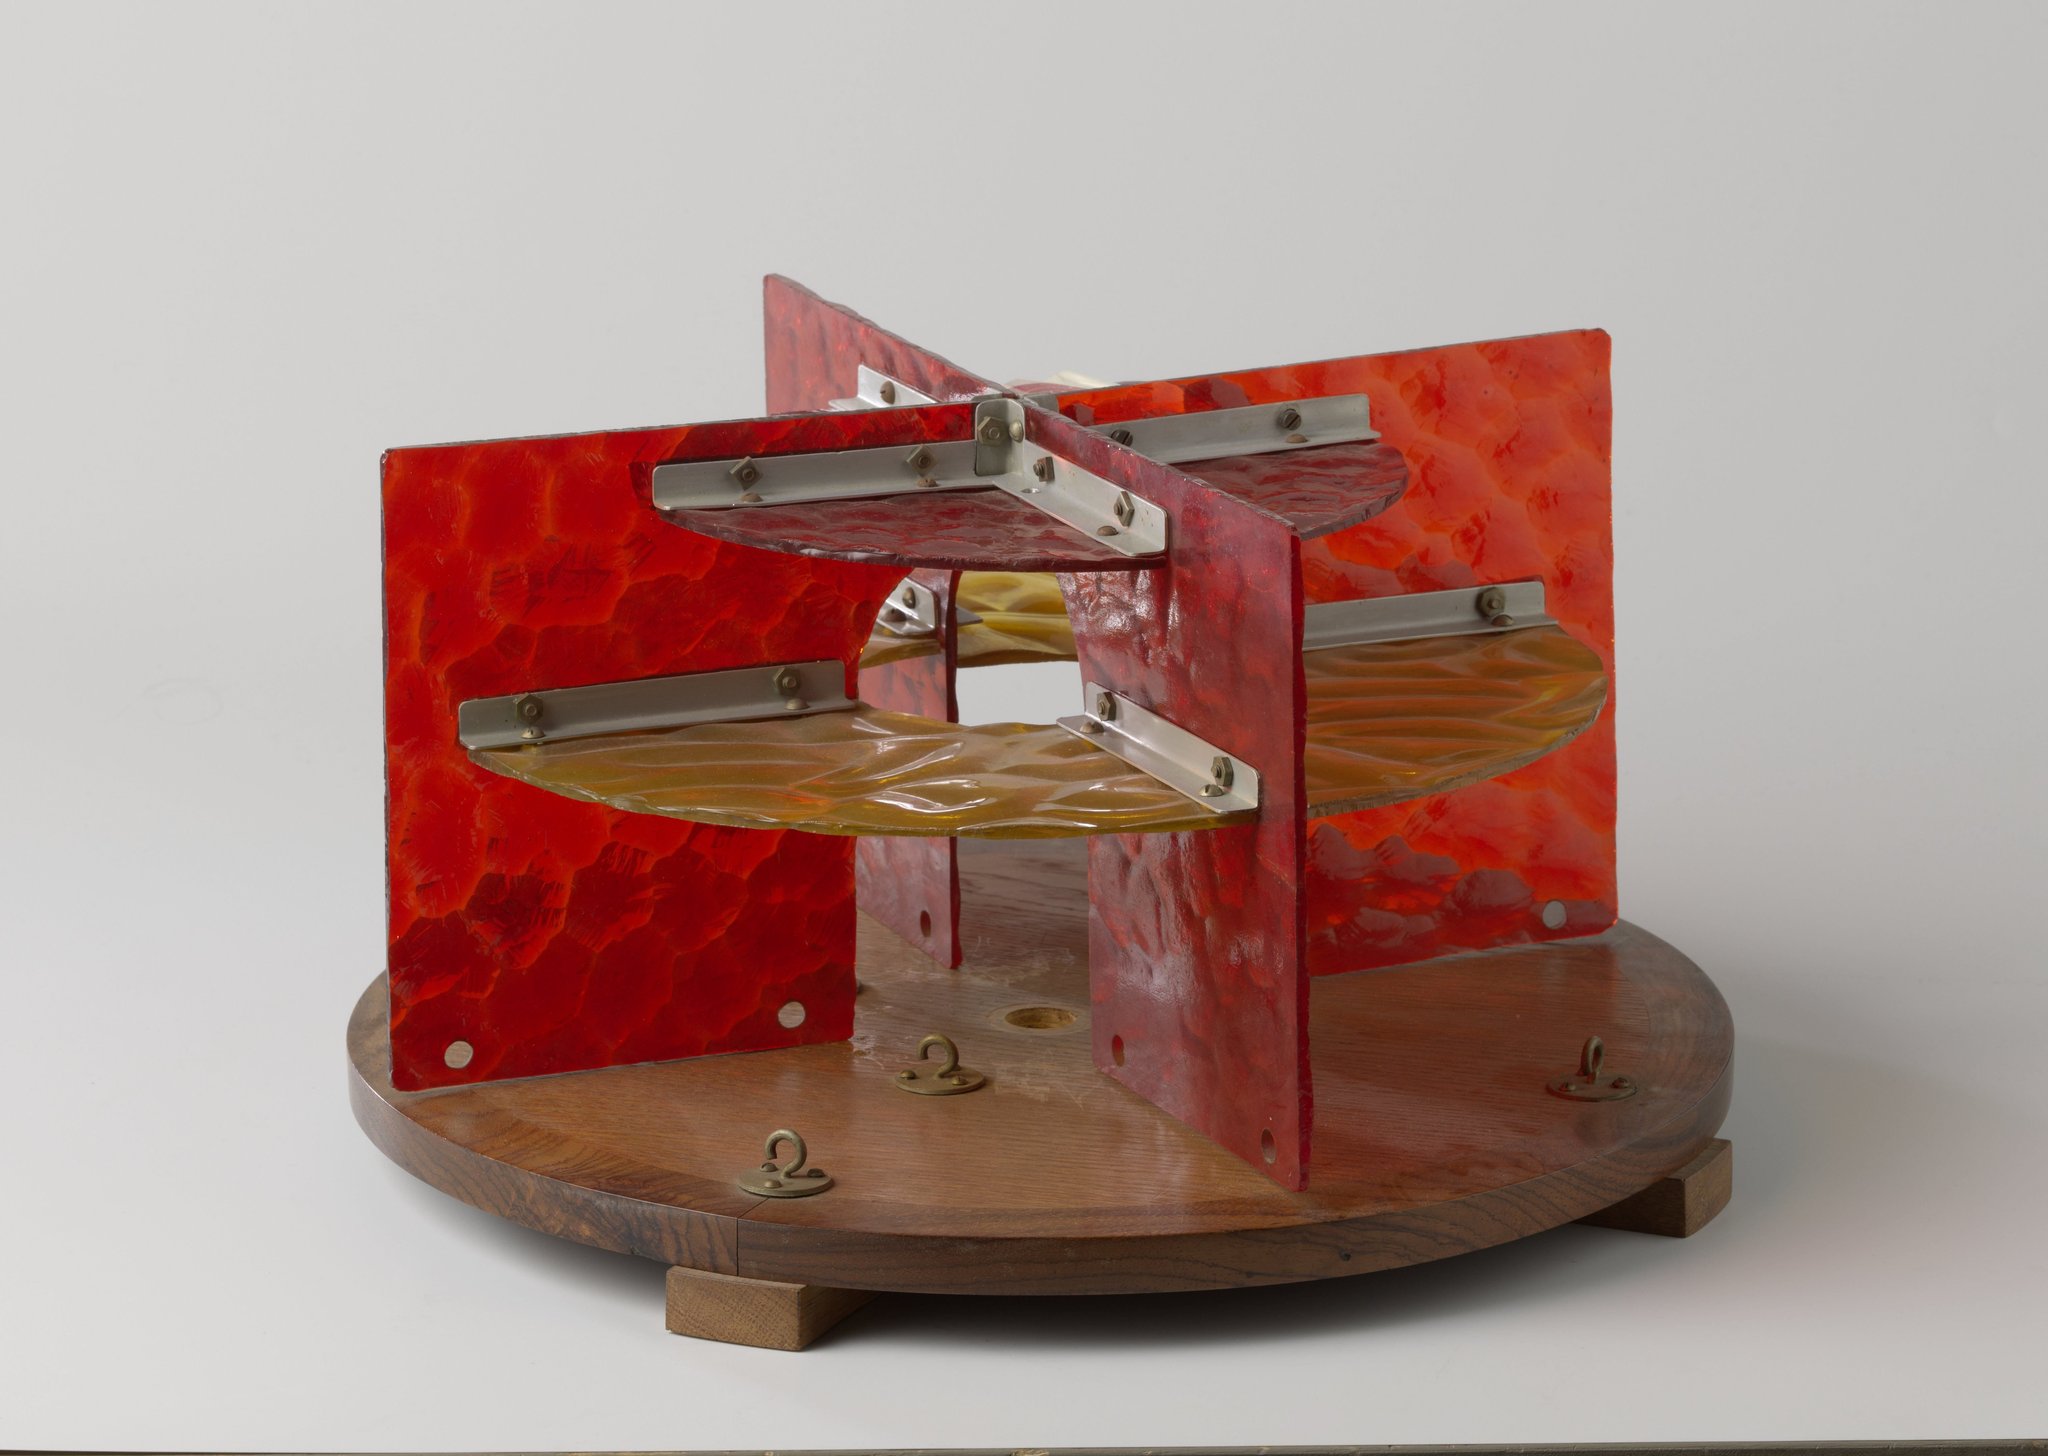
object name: lighting device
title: Plafondlamp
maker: ernst schubad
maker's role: interieurontwerper, meubelontwerper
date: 1910-1927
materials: aluminum, glass, wood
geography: netherlands